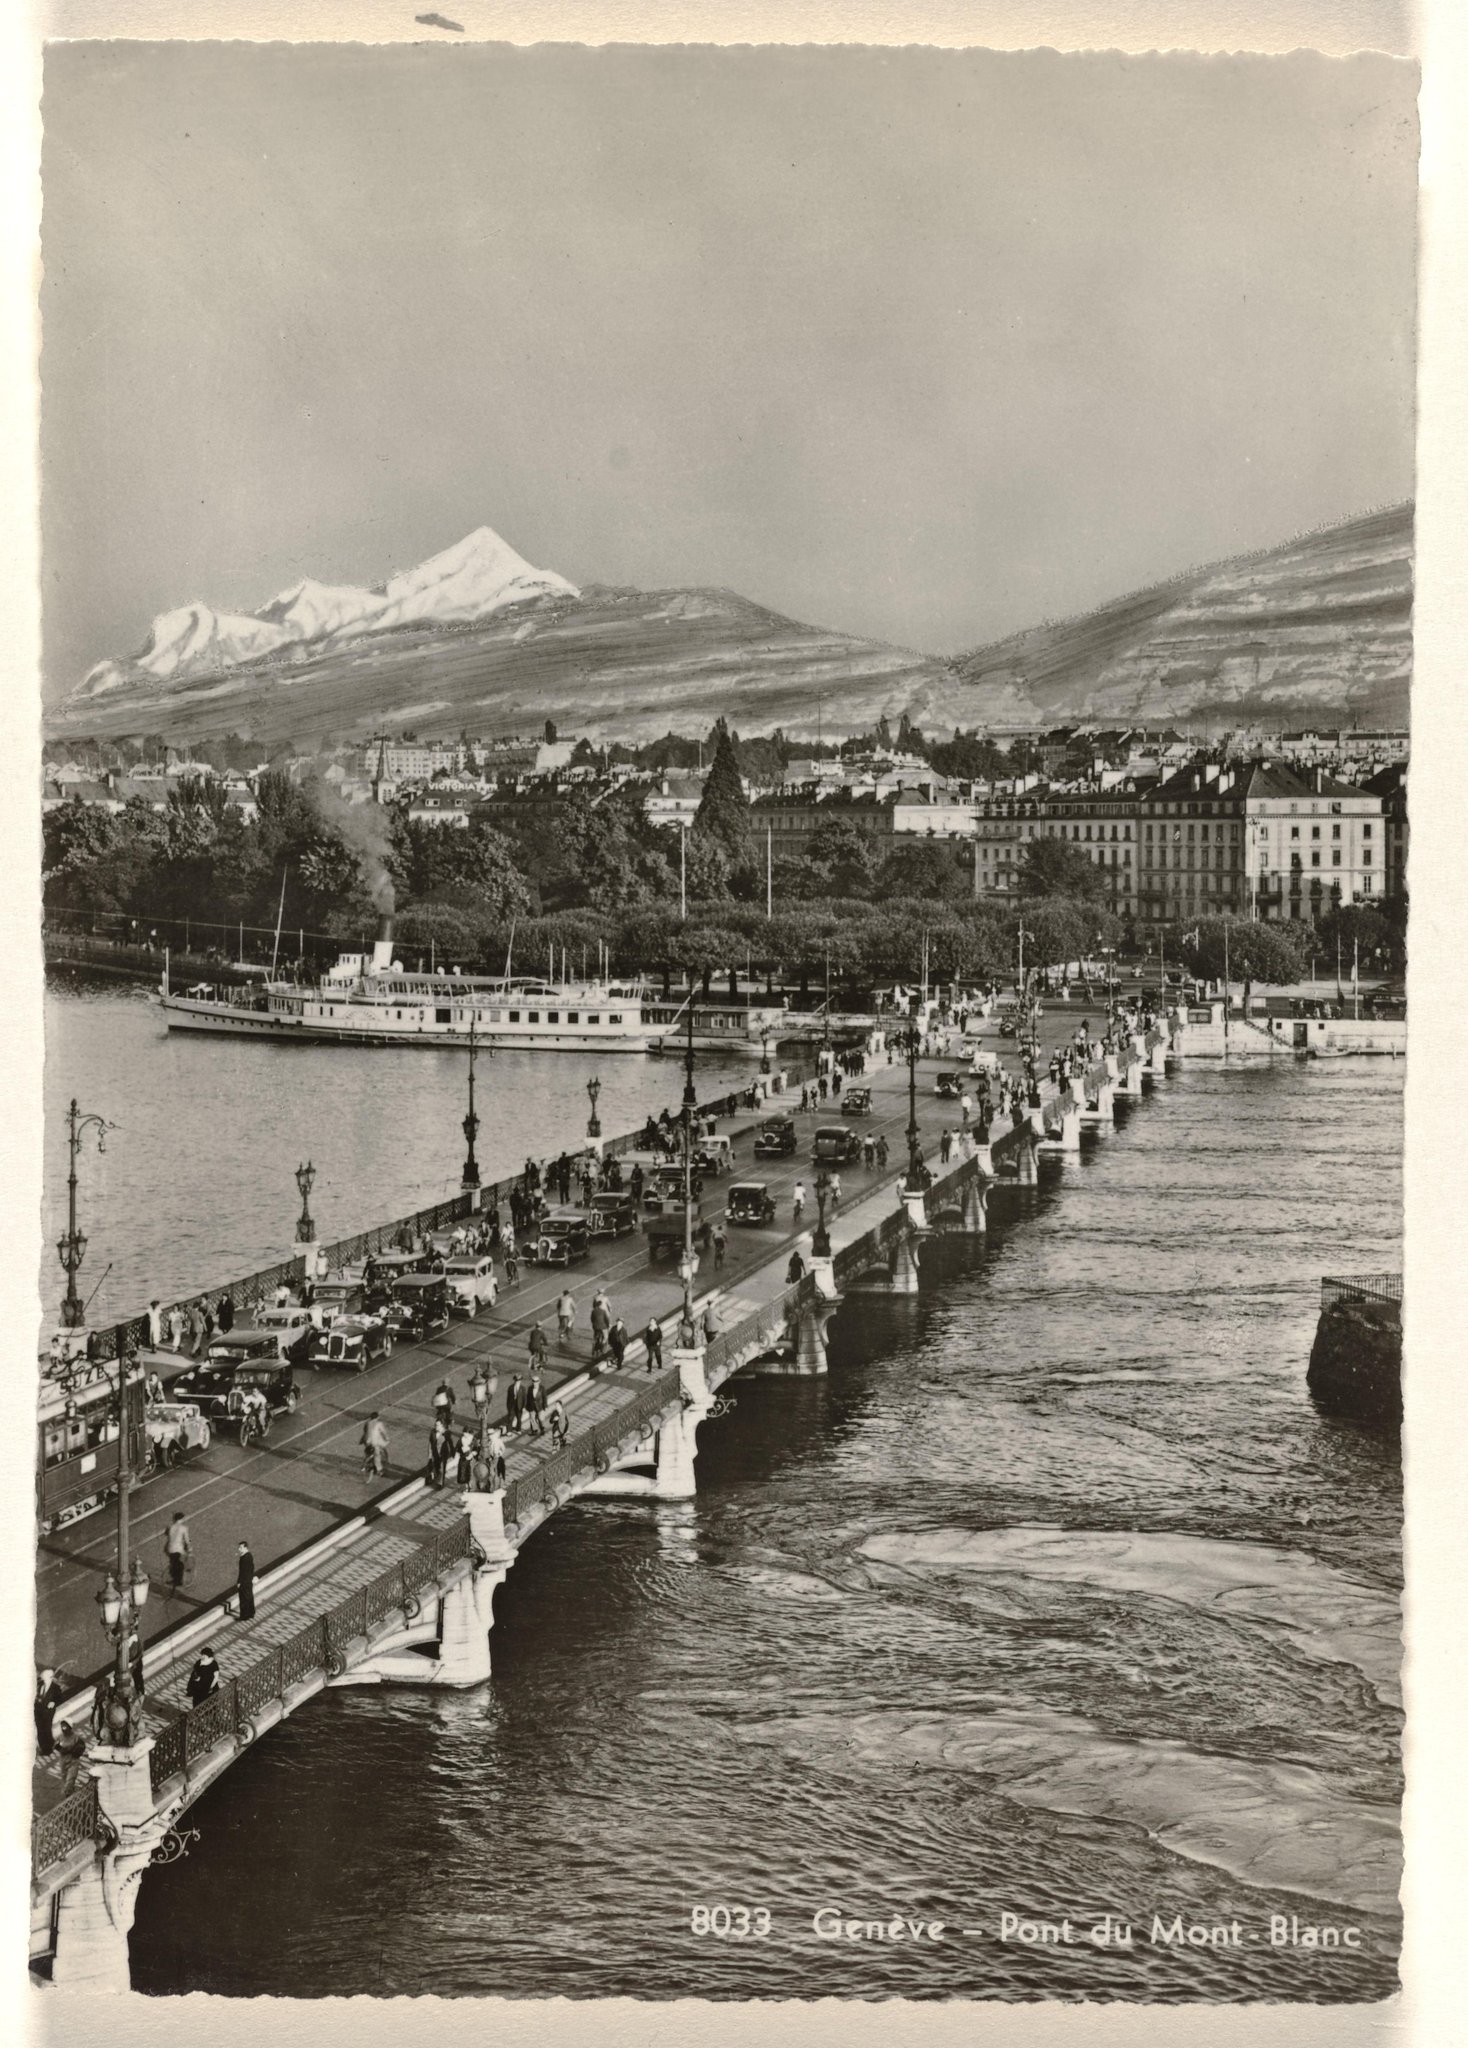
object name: ansichtkaart, prentbriefkaart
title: Brug met verkeer over een rivier in Genève, met de Mont-Blanc en bebouwing op de achtergrond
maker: Anonymous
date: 1949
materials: photographic support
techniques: gelatin silver print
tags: genève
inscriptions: date: ‘18.2.1949.’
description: Brug met verkeer over een rivier in Genève, met de Mont-Blanc en bebouwing op de achtergrond.